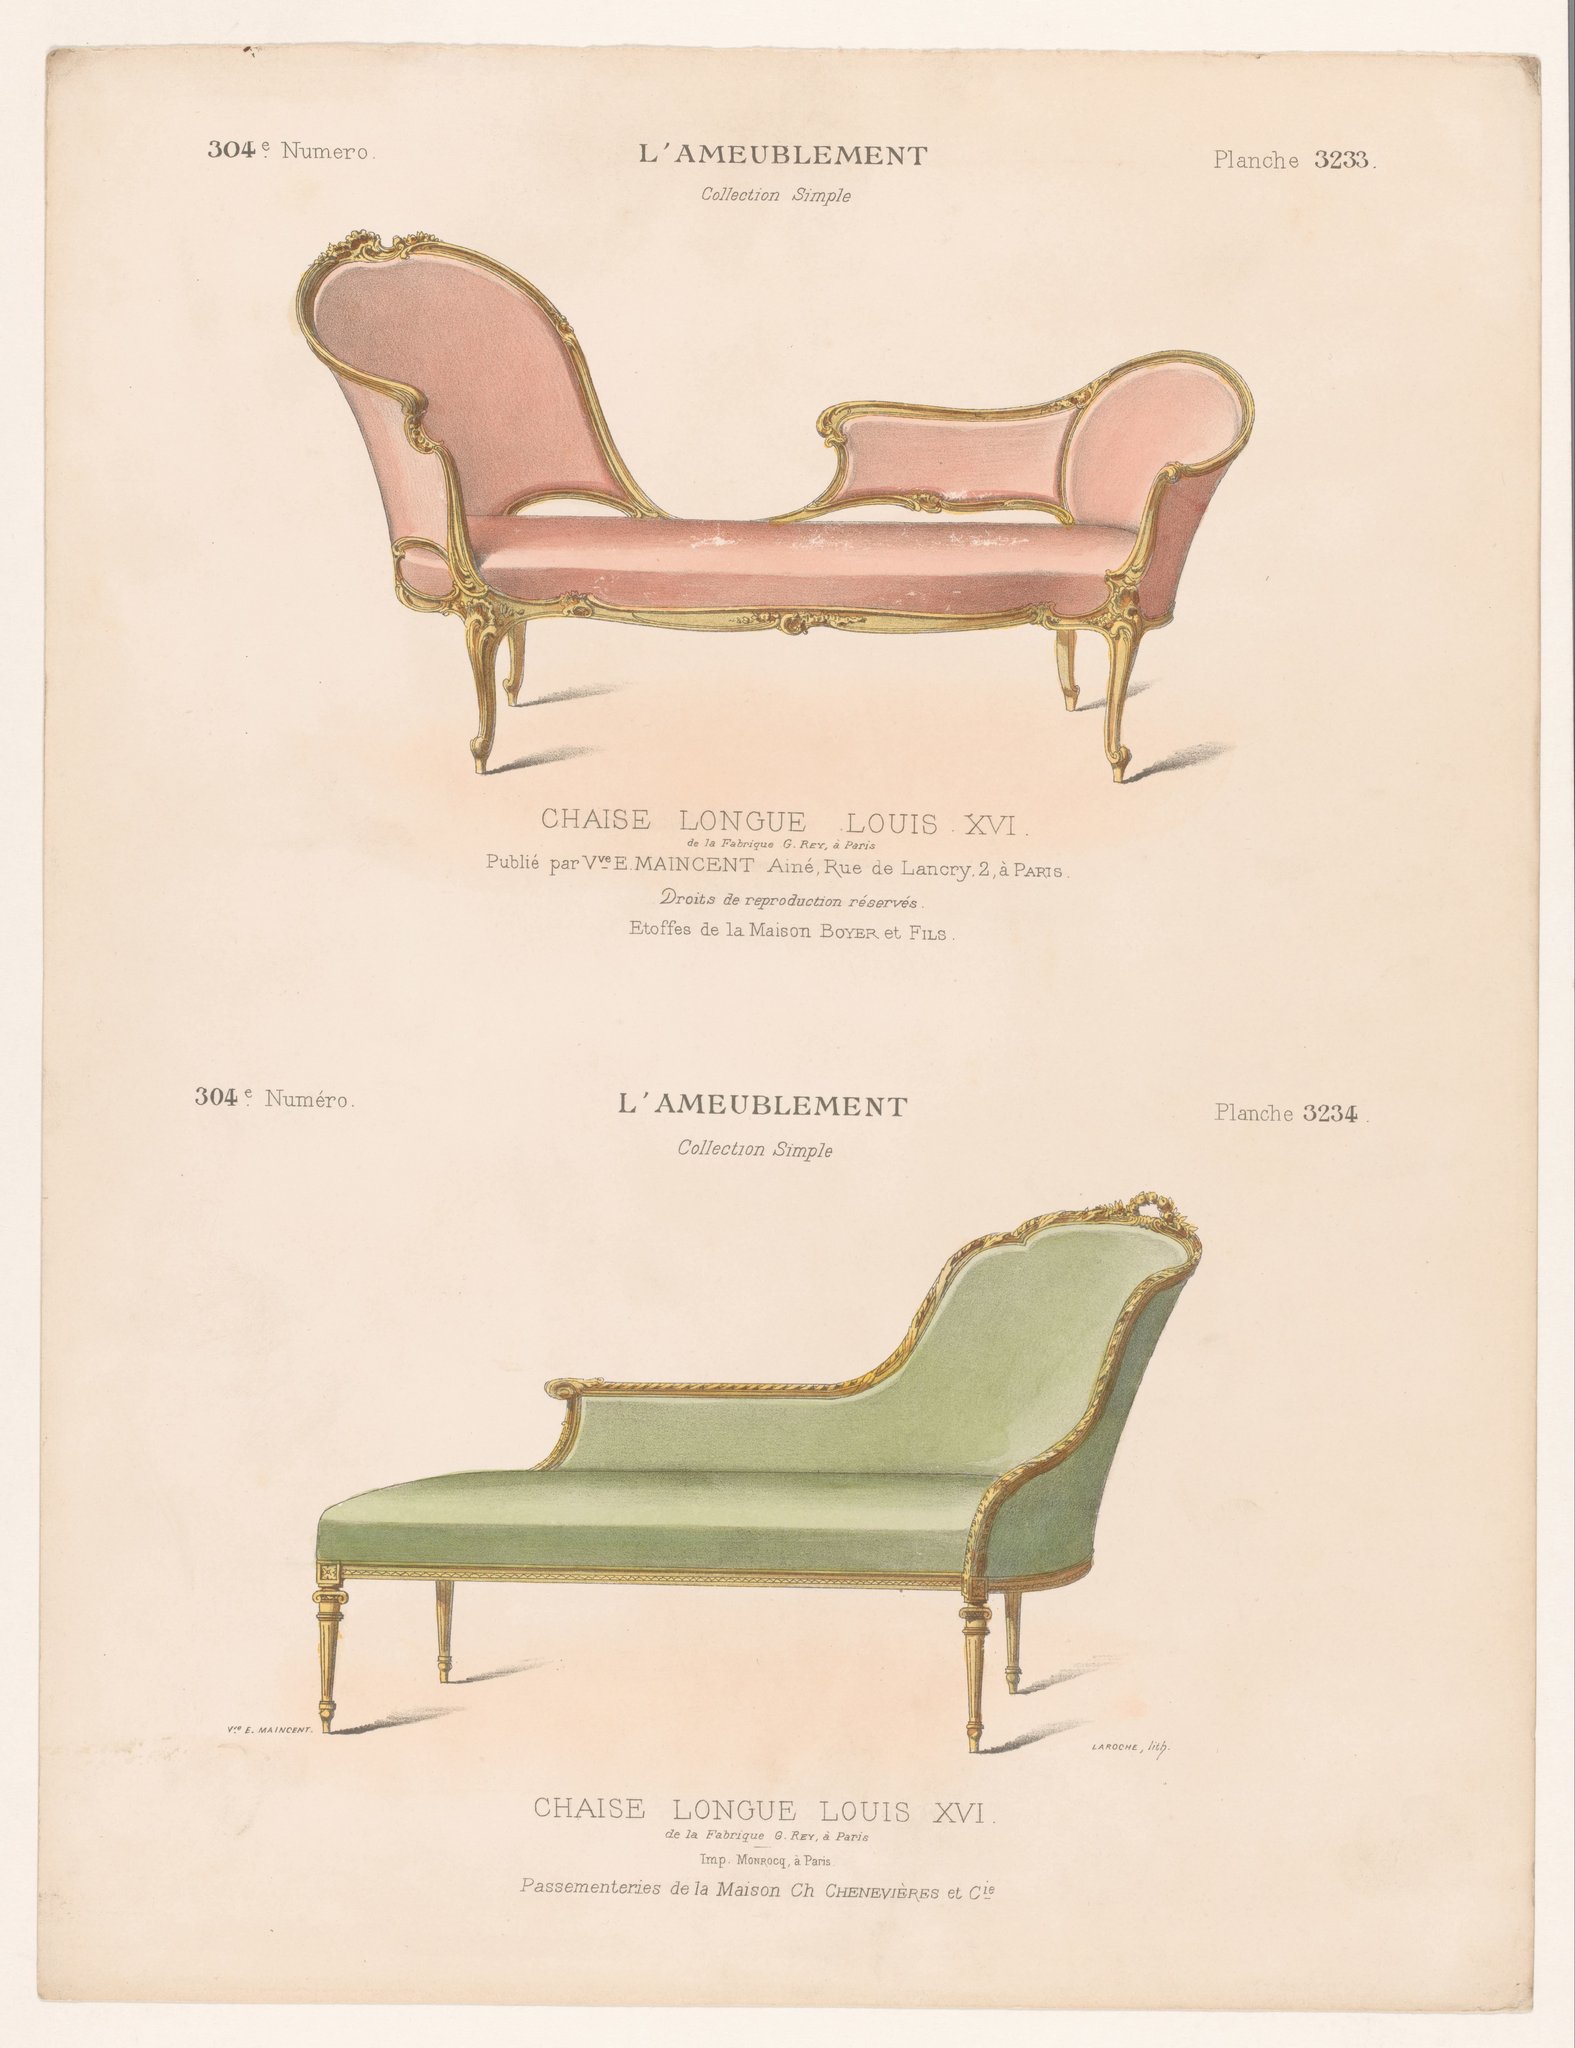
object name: print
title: Twee chaise longues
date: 1895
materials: paper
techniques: hand coloring, lithograph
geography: paris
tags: seating furniture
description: Twee chaise longues in de Lodewijk XVI-stijl. Prent uit 304e nummer (livraison).